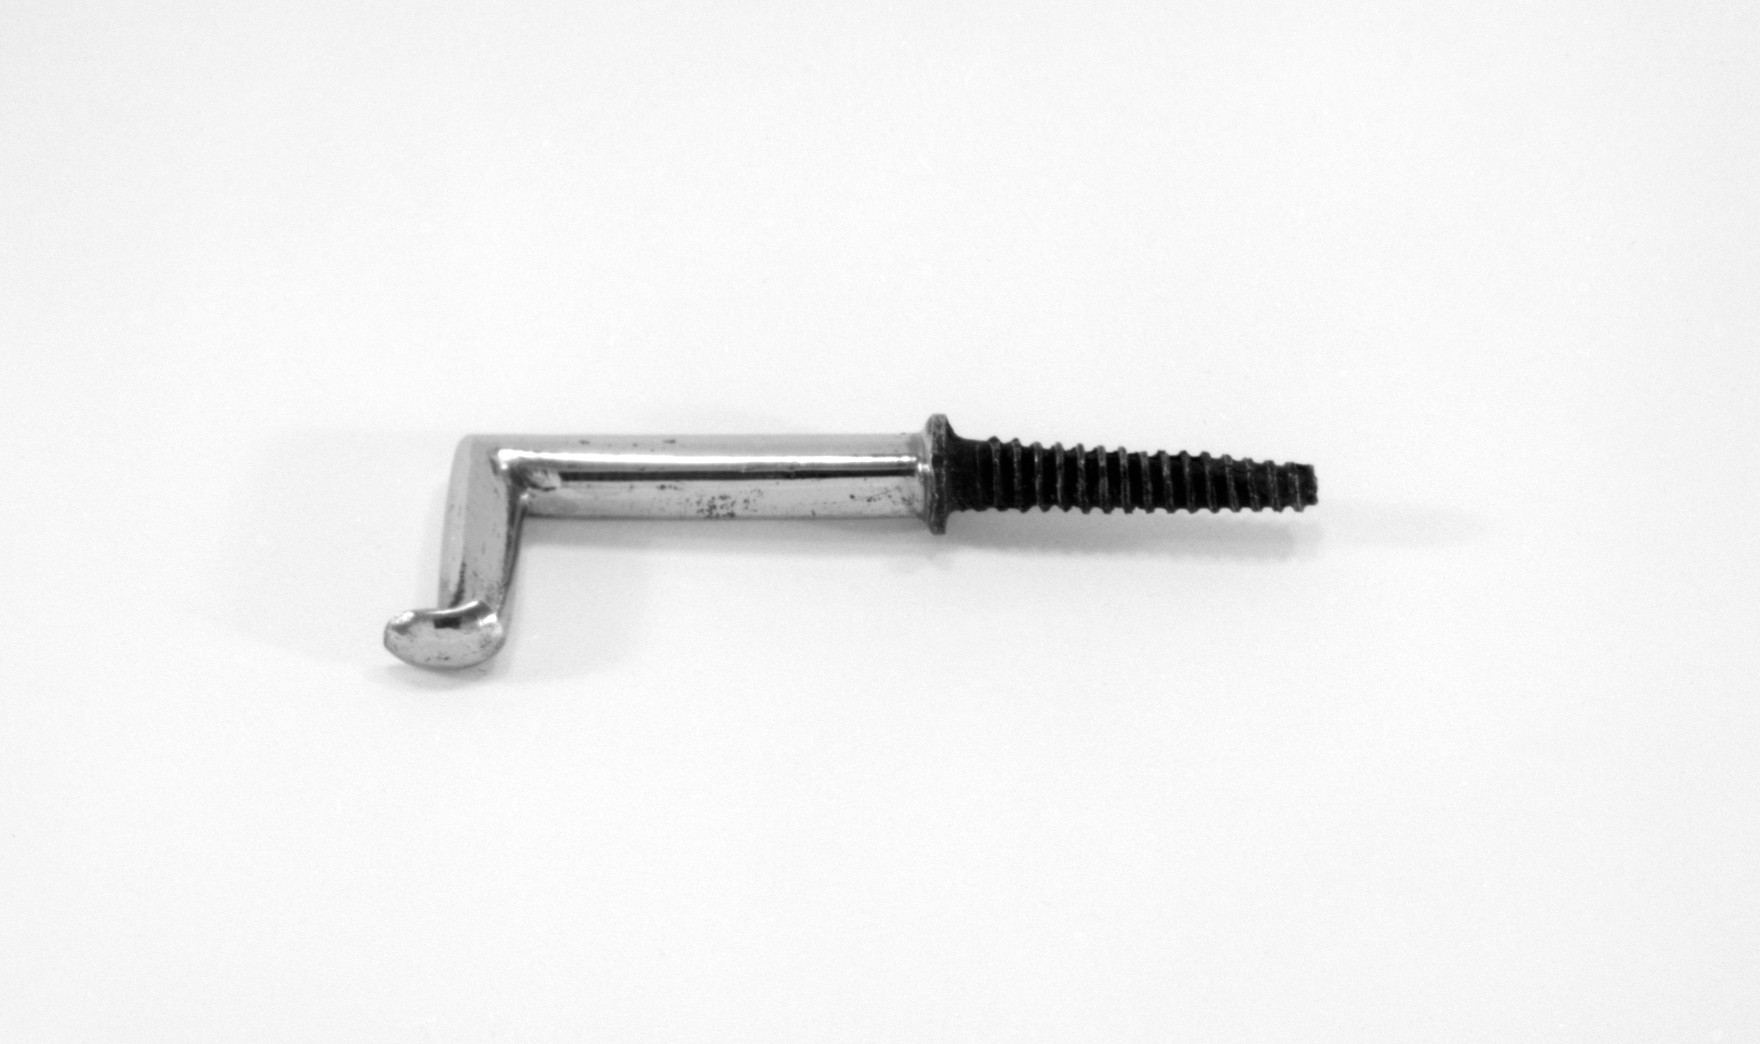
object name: hook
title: Hook (part of a set)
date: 1848-1849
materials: steel